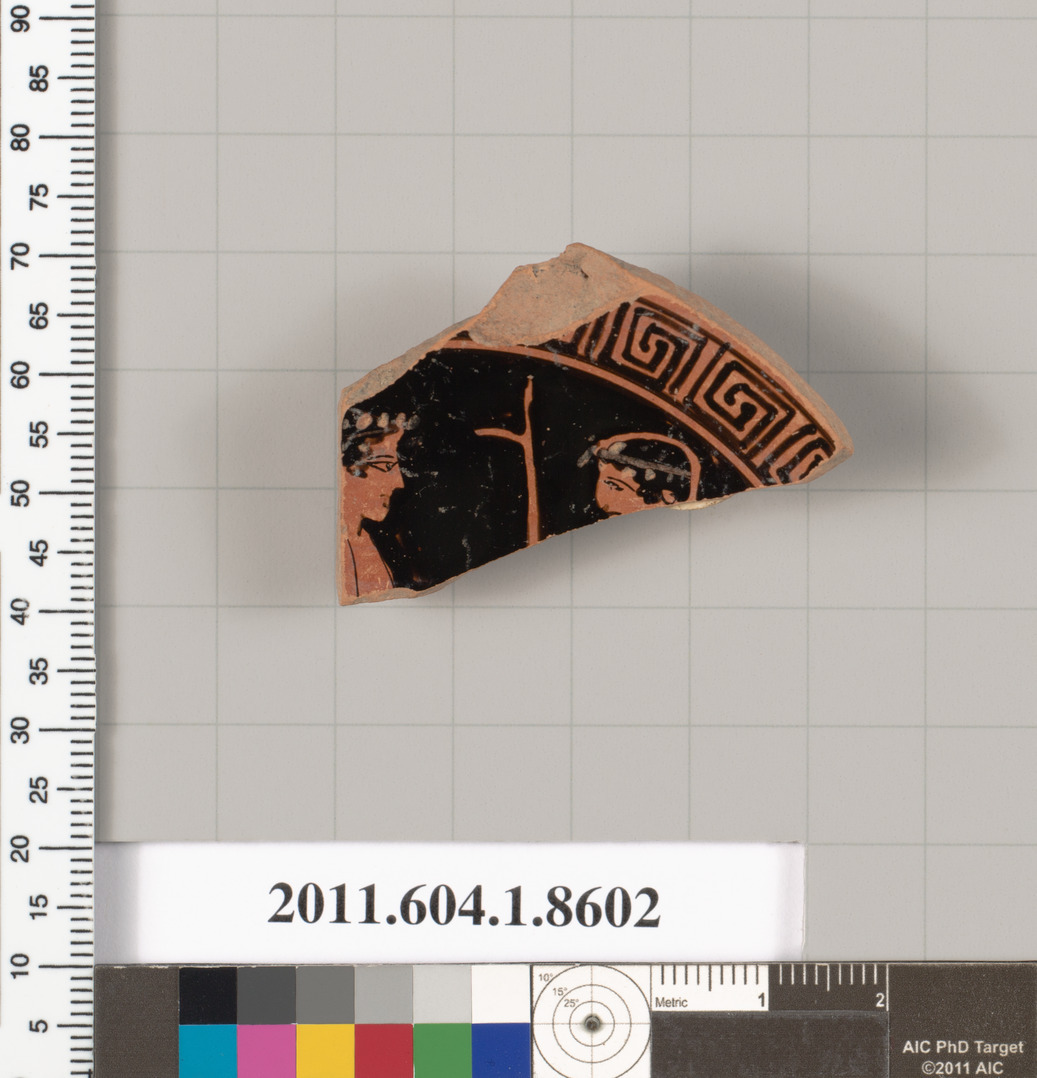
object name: kylix fragment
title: Terracotta fragment of a stemless kylix (drinking cup)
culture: greek, attic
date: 460-450 BCE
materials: terracotta